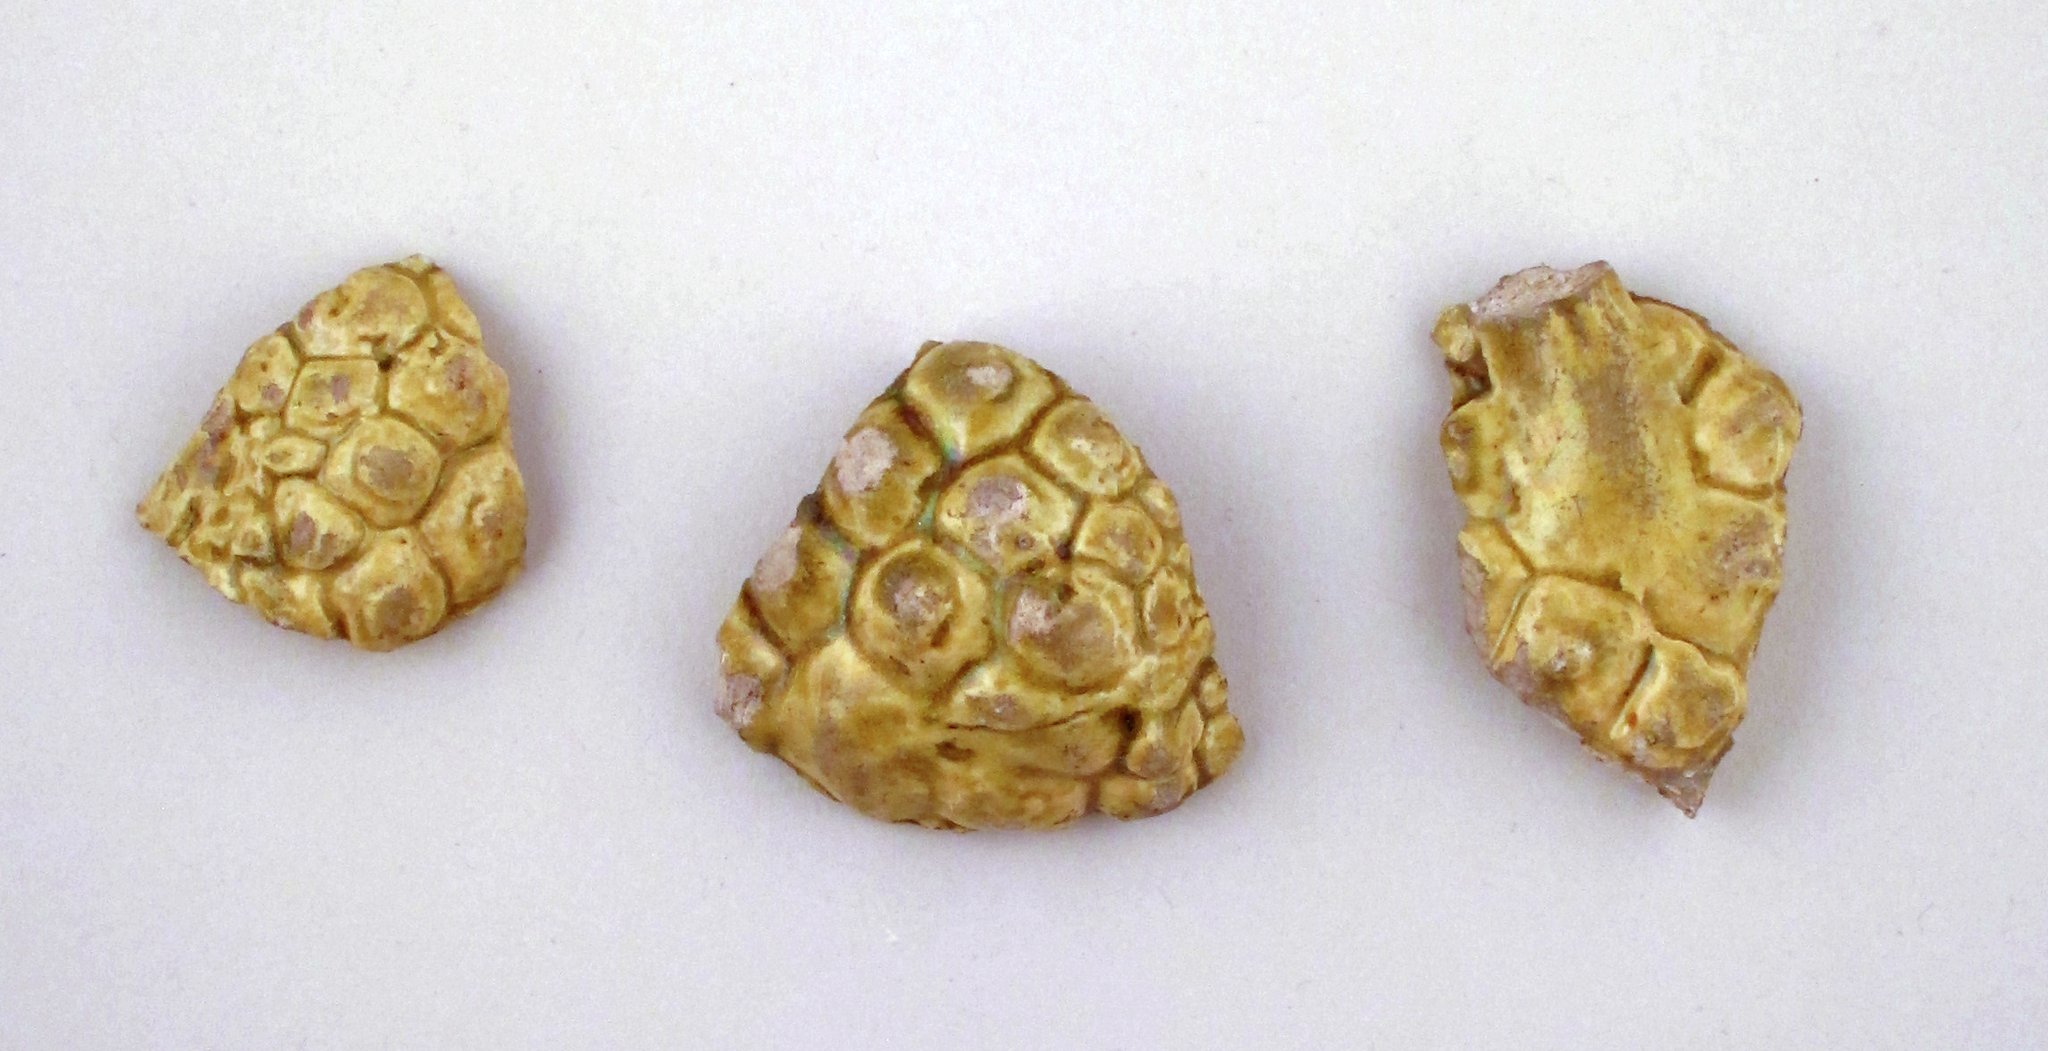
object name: vase fragment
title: Vase fragments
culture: roman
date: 670 BCE-330 CE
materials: terracotta